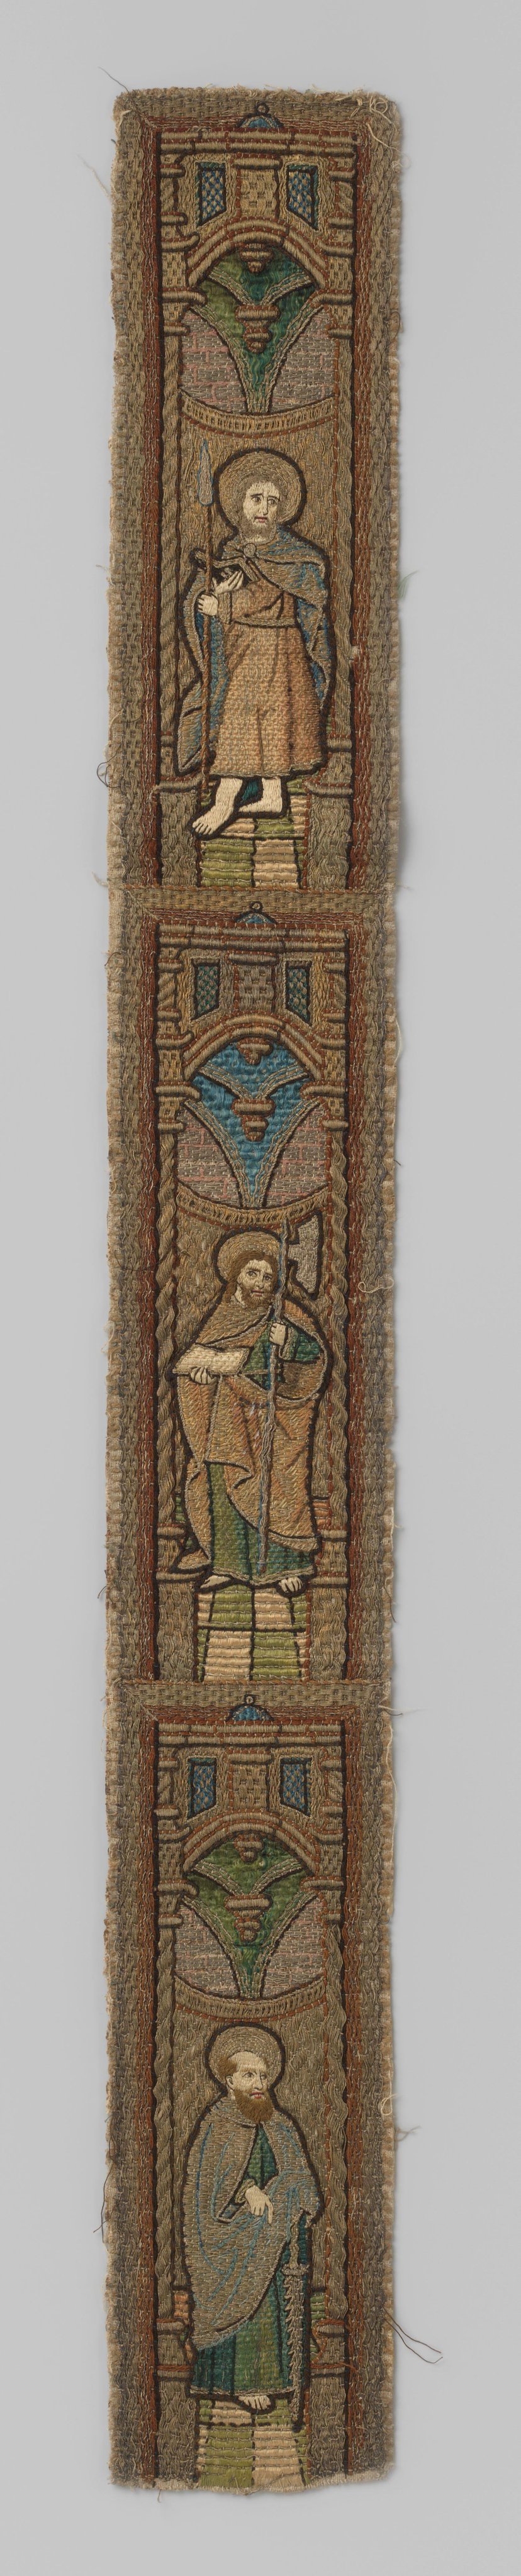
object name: aurifries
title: Fragment van een aurifries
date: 1490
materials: textile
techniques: embroidered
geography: netherlands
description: Fragment van een aurifries, met borduurwerk. Het fragment heeft drie nissen met een afbeelding van de heiligen Mattheus (met speer en boek), Matthias (met hellebaard en boek) en Simon (met zaag).